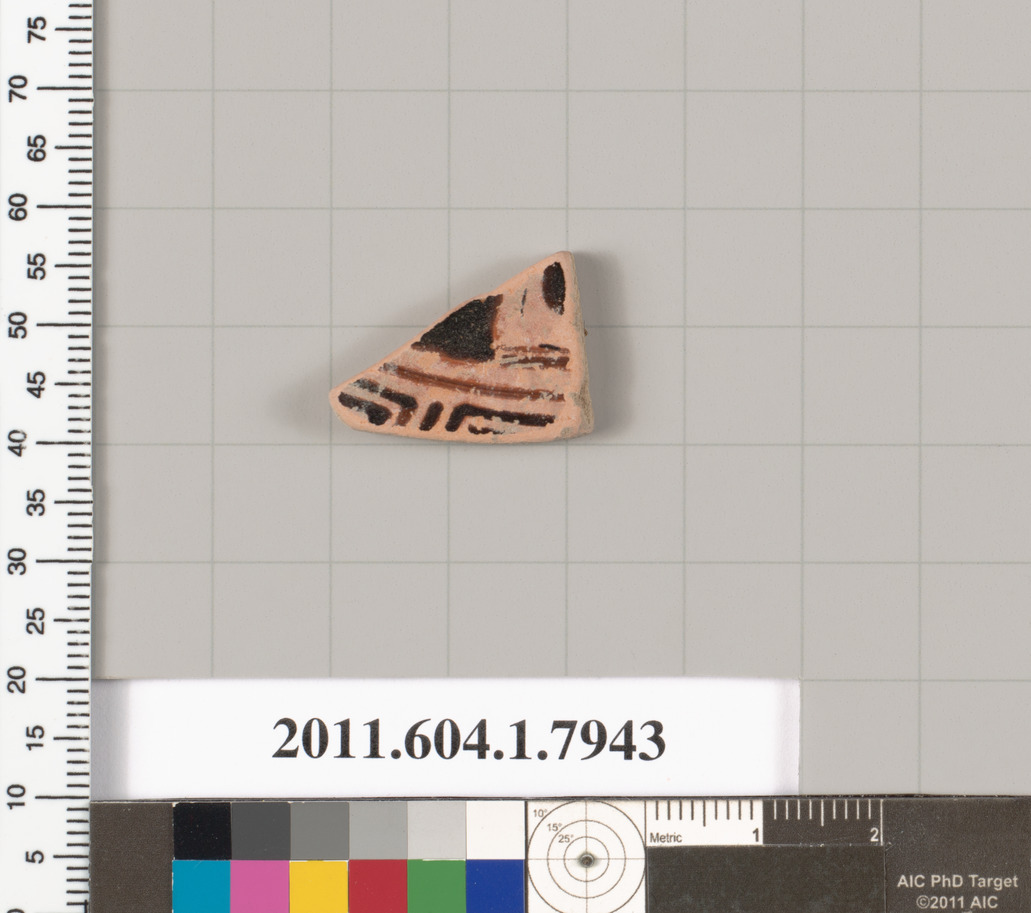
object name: kylix fragment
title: Terracotta fragment of a kylix (drinking cup)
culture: greek, attic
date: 460-450 BCE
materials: terracotta